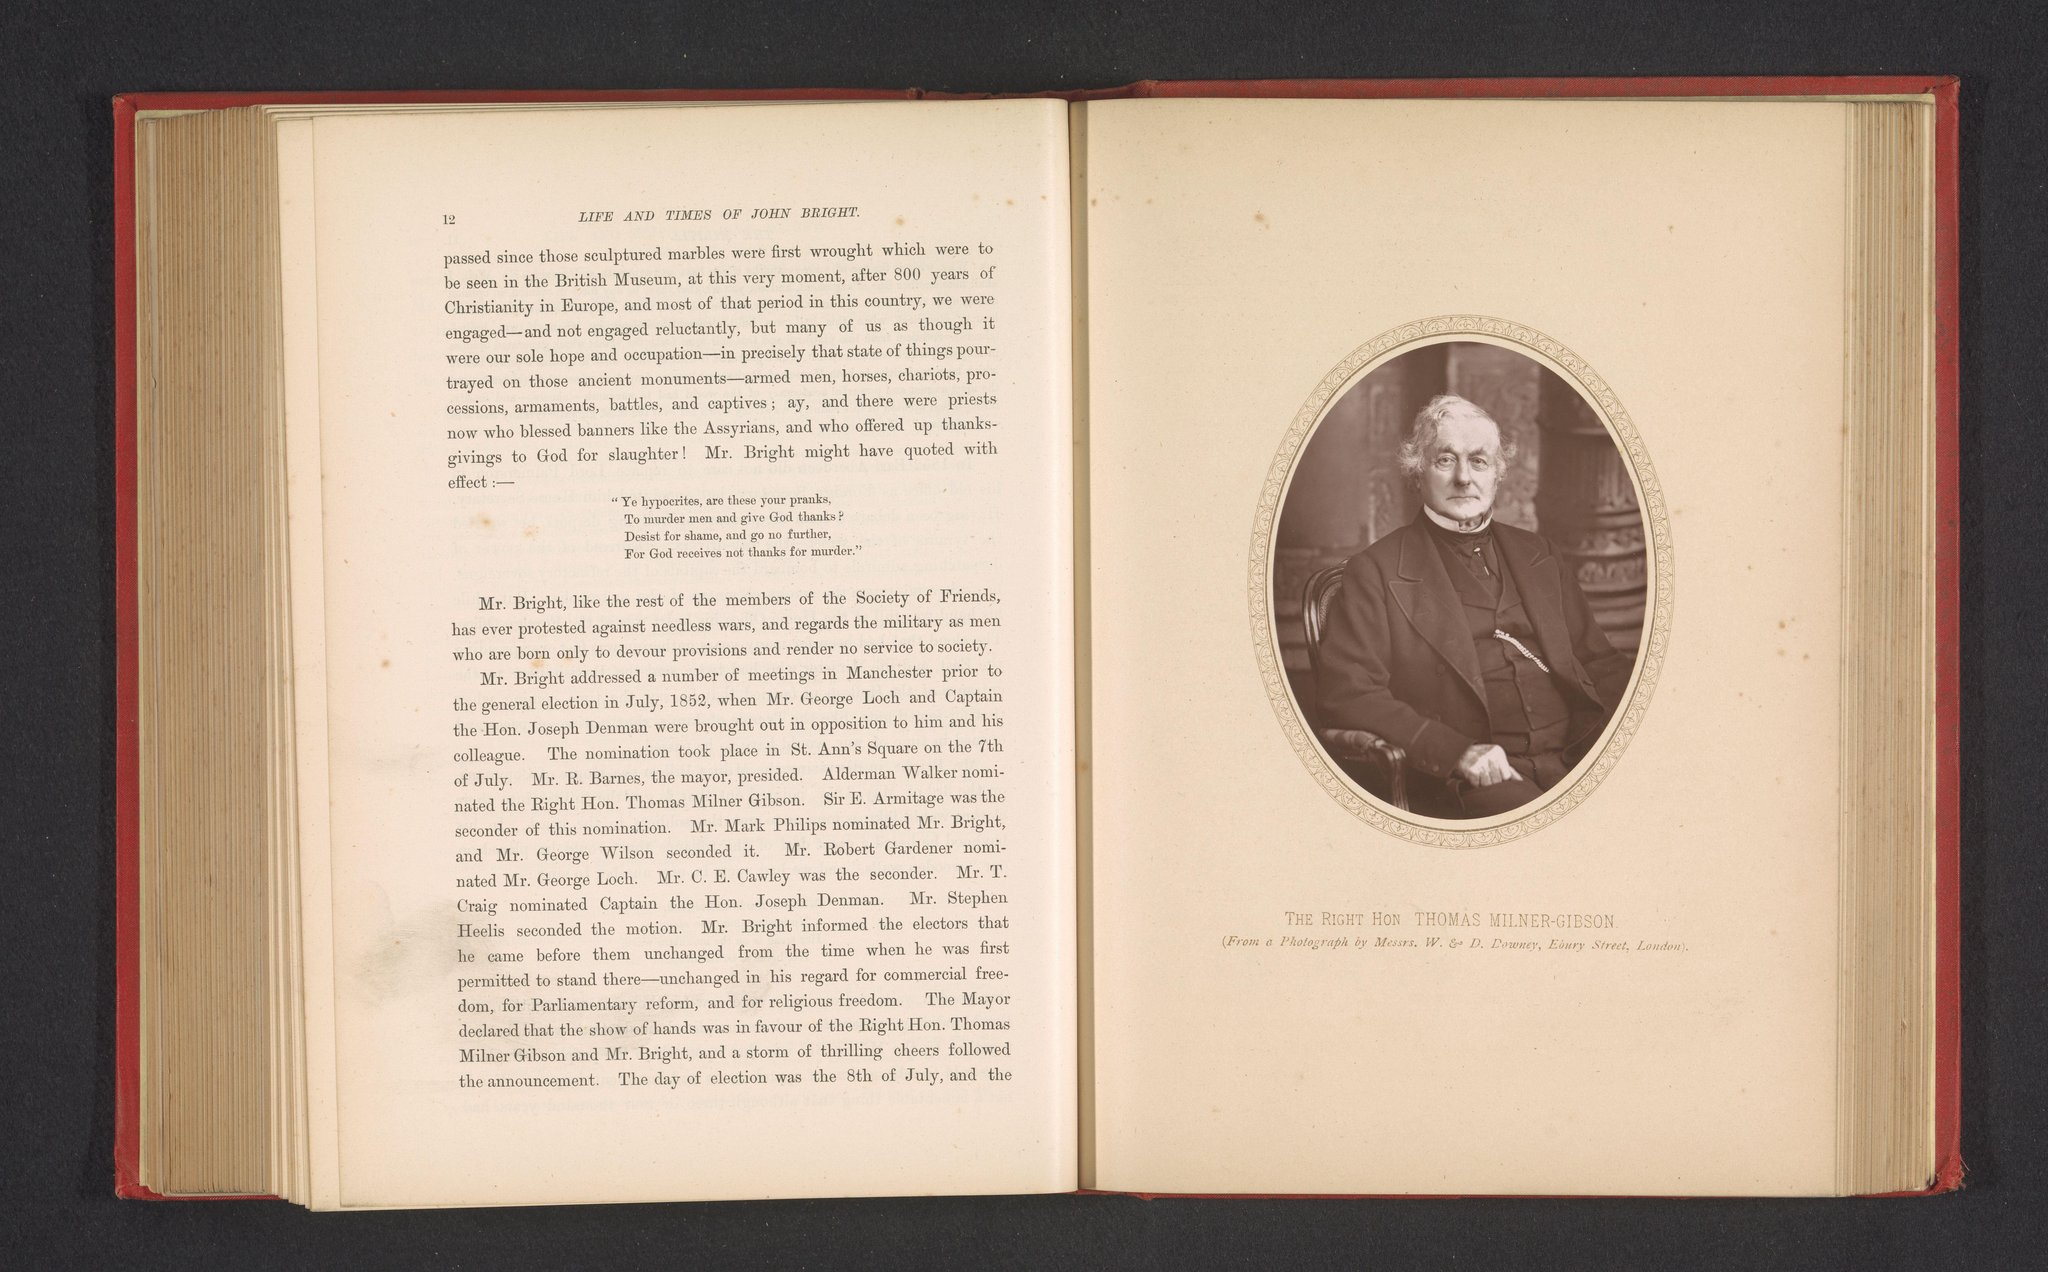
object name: photomechanical print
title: Portret van Thomas Milner Gibson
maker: Anonymous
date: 1874-1884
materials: paper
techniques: woodburytype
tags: politician, adult man, politician, e.g. party leader